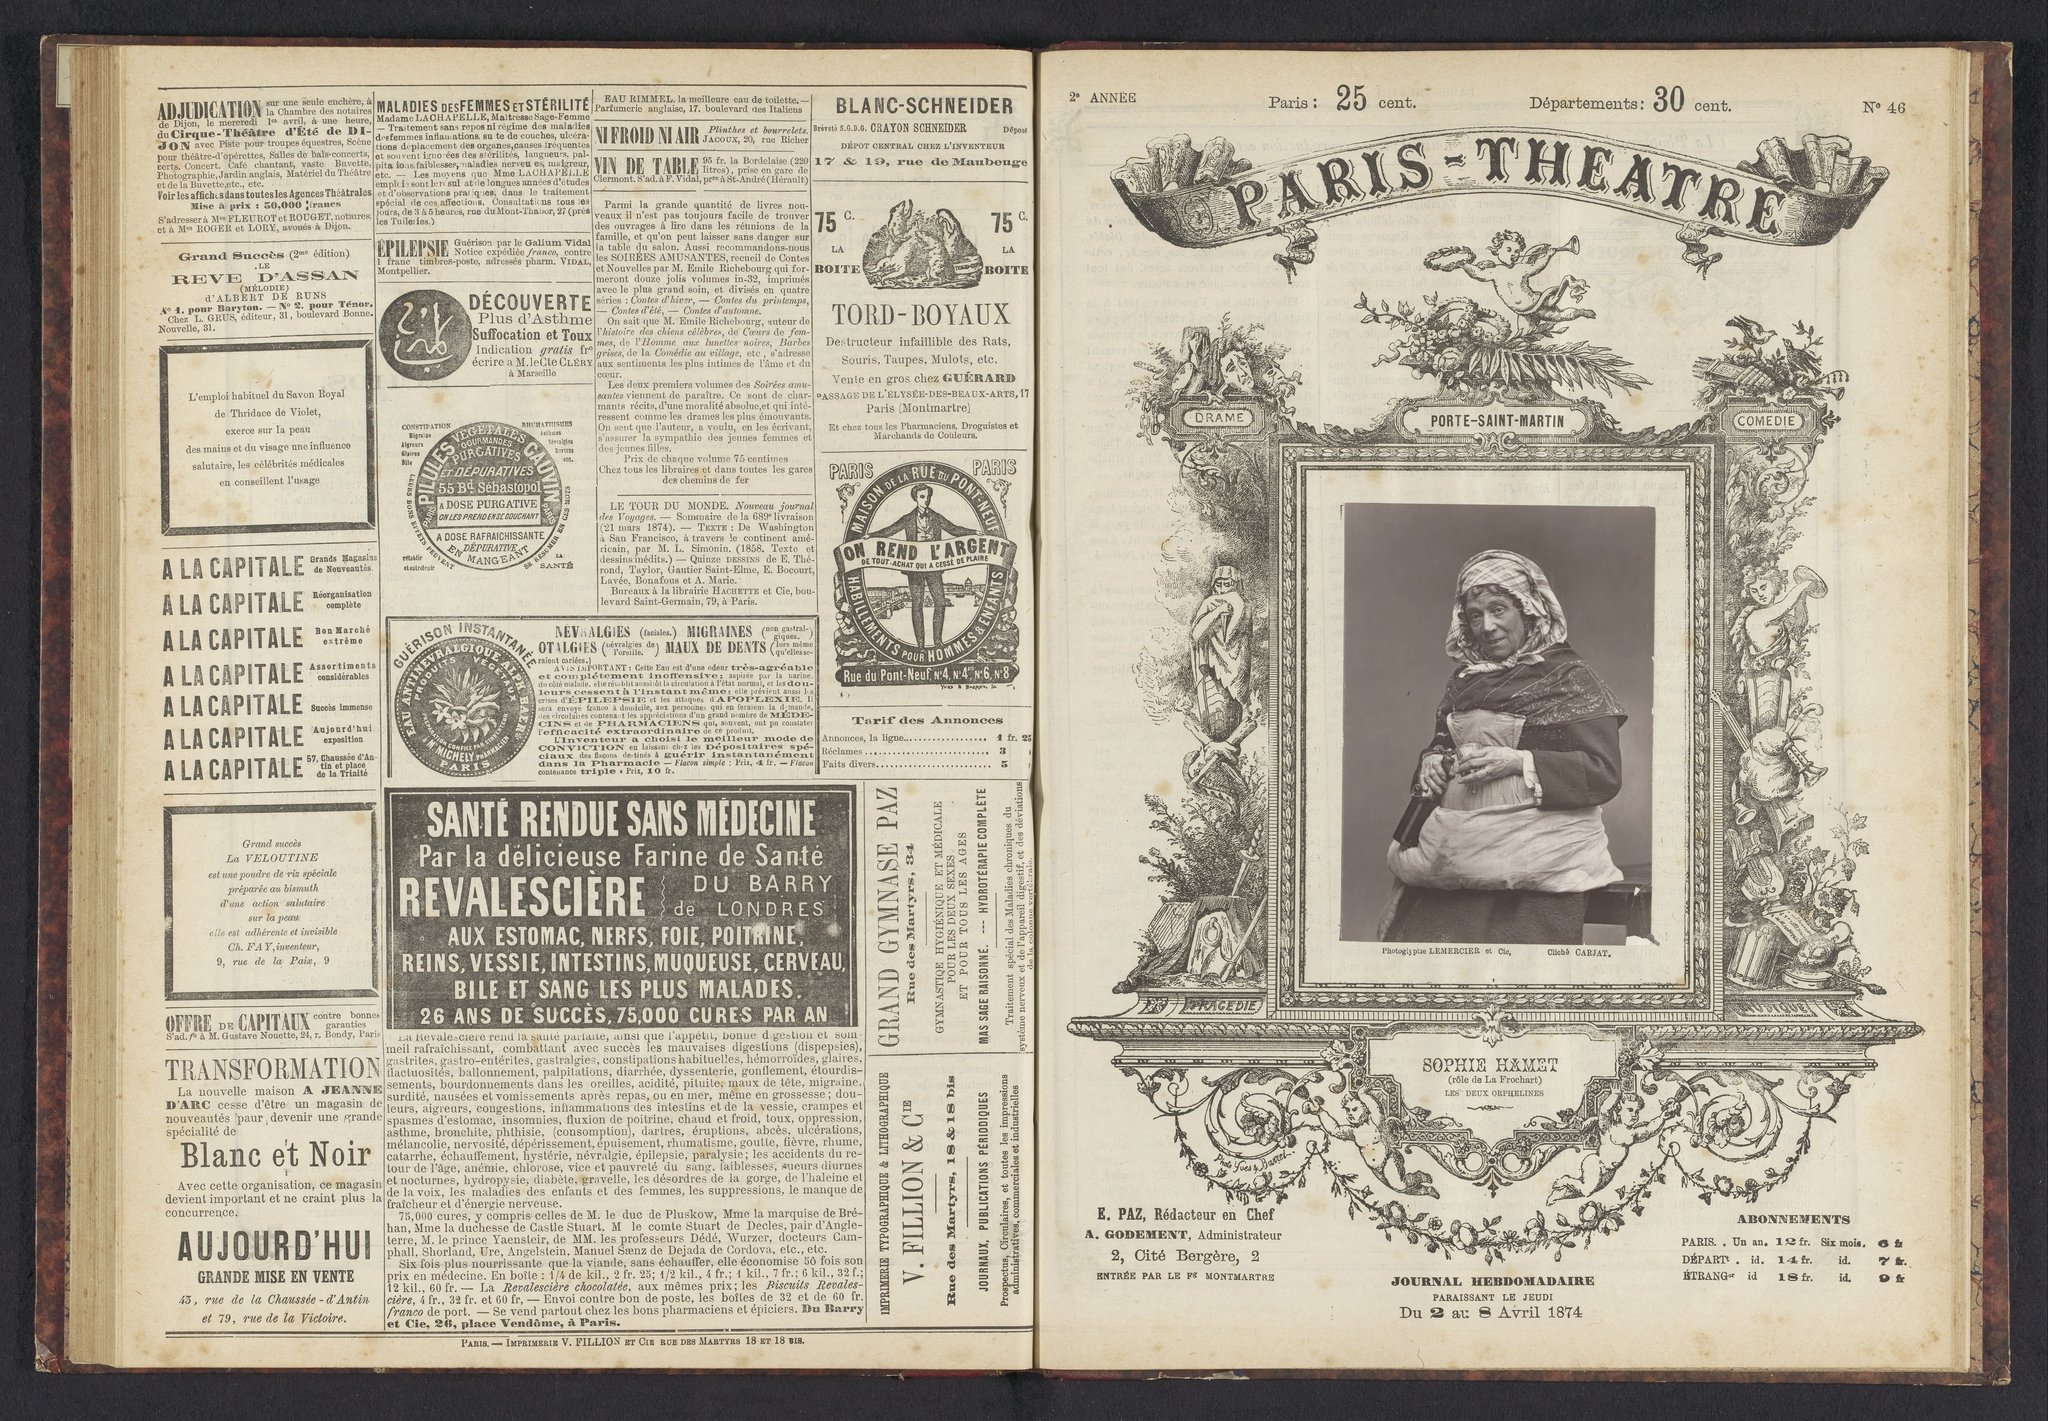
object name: page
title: Portret van Sophie Hamet als La Frochart in Les Deux Orphelines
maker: étienne carjat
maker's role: draughtsman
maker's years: 1828-1906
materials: paper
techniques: woodburytype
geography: france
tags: portrait of actor, actress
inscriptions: inscription: ‘Journal hebdomadaire paraissant le Jeudi Du 2 au 8 Avril 1874’, number: ‘No 46.’